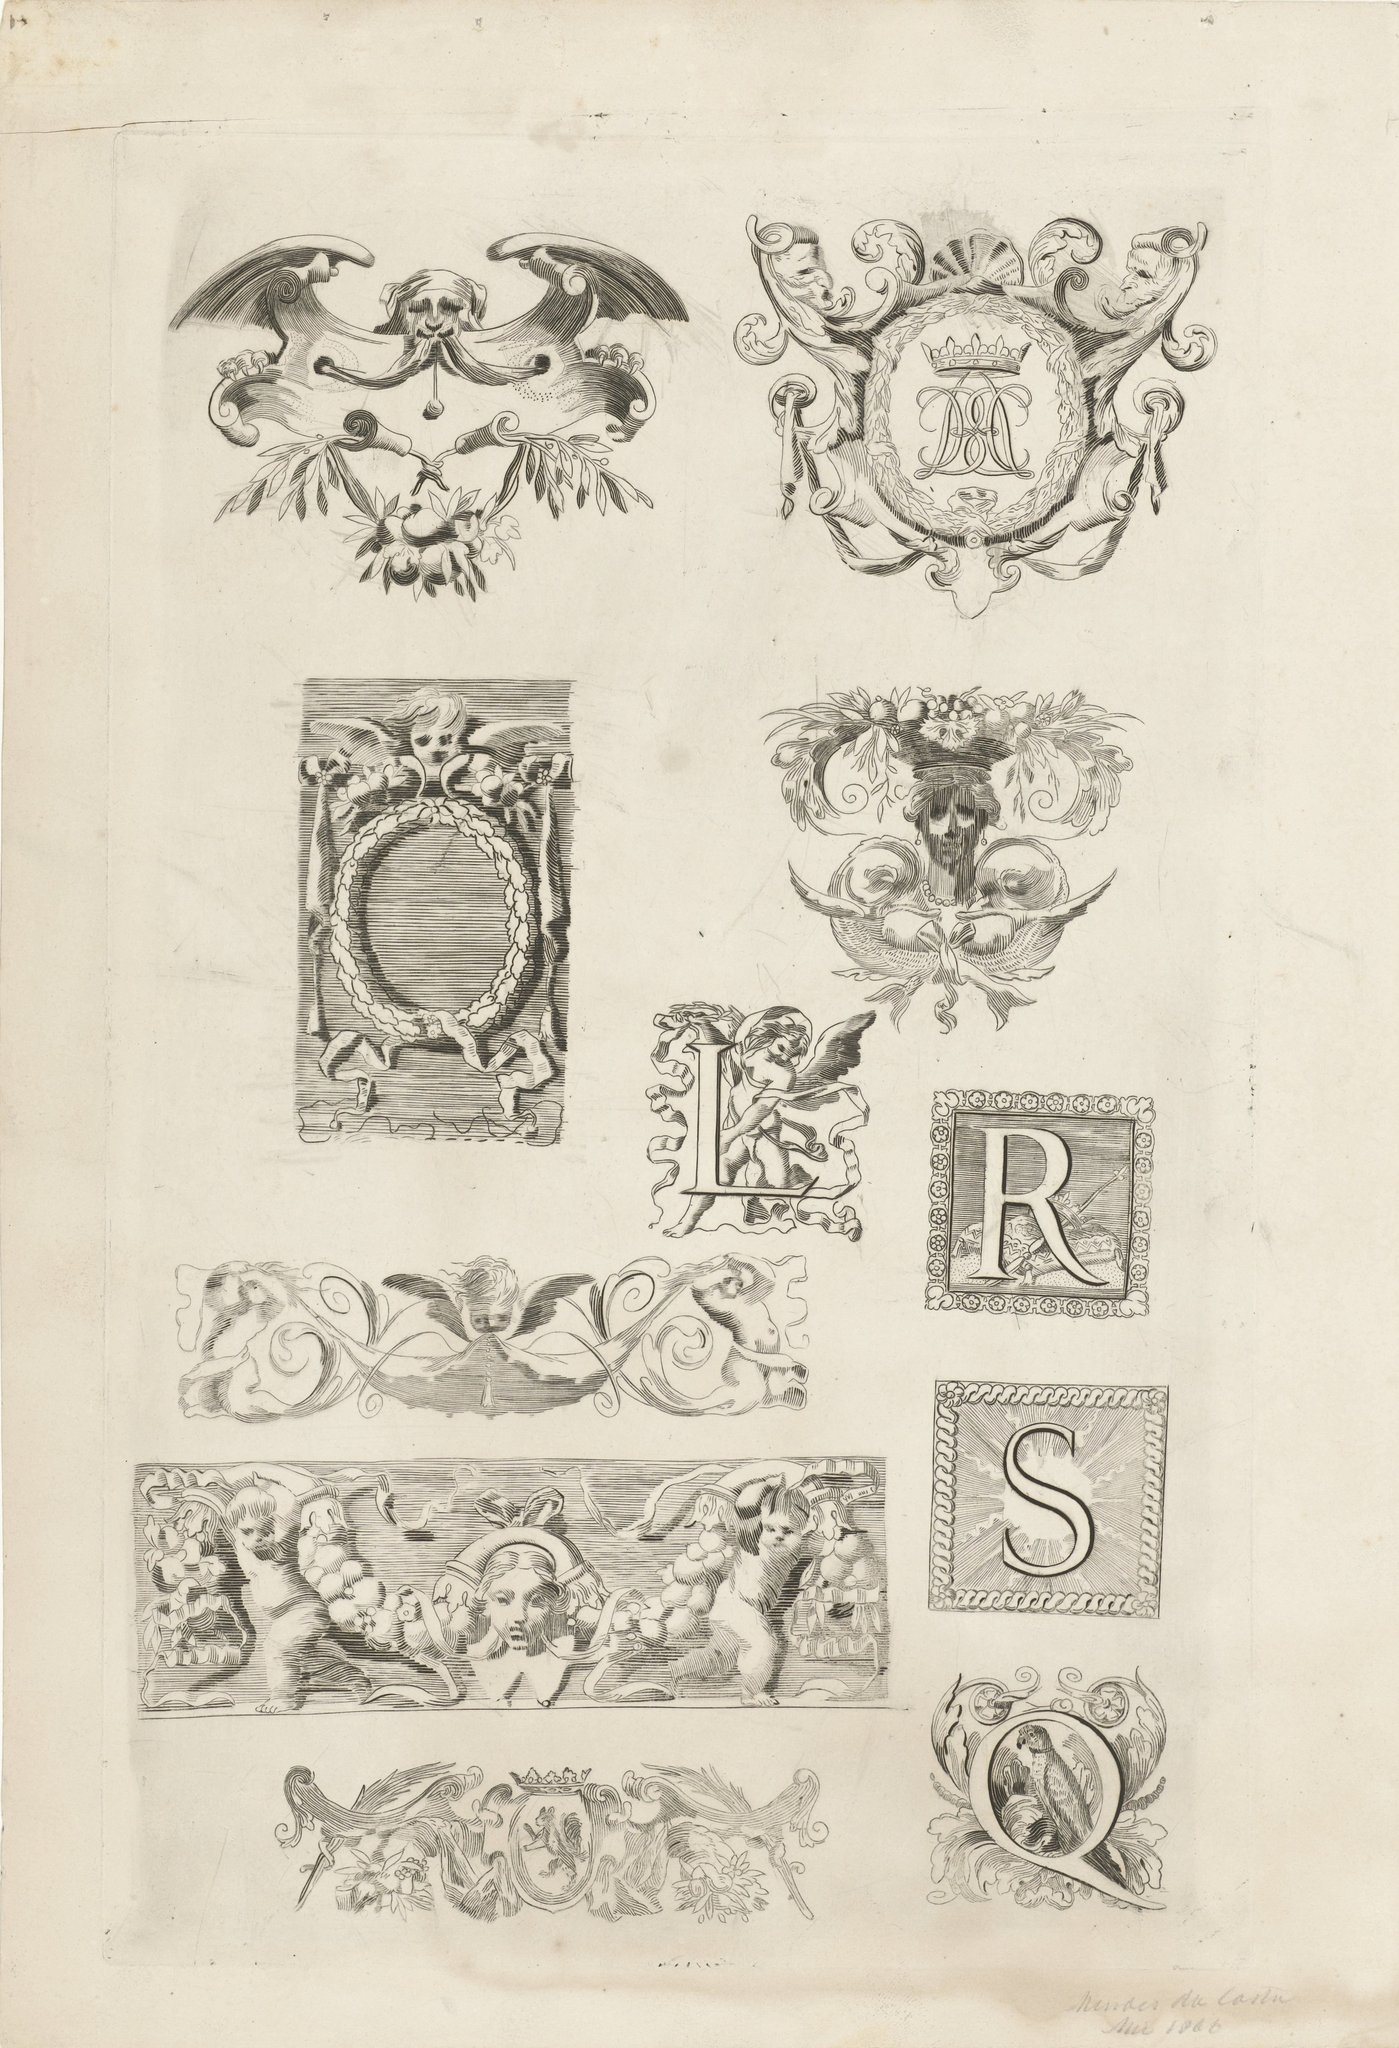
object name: print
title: Verschillende ornamentele ontwerpen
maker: samuel henri mendes da costa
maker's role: draughtsman, print maker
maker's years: 1845-1923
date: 1855-1923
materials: paper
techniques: etching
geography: amsterdam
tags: initial, letter combinations such as letterword, anagram, letter square, monogram, etc.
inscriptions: collector's mark: Lugt 2228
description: Elf verschillende ontwerpen voor initialen, monogrammen en siervignetten.